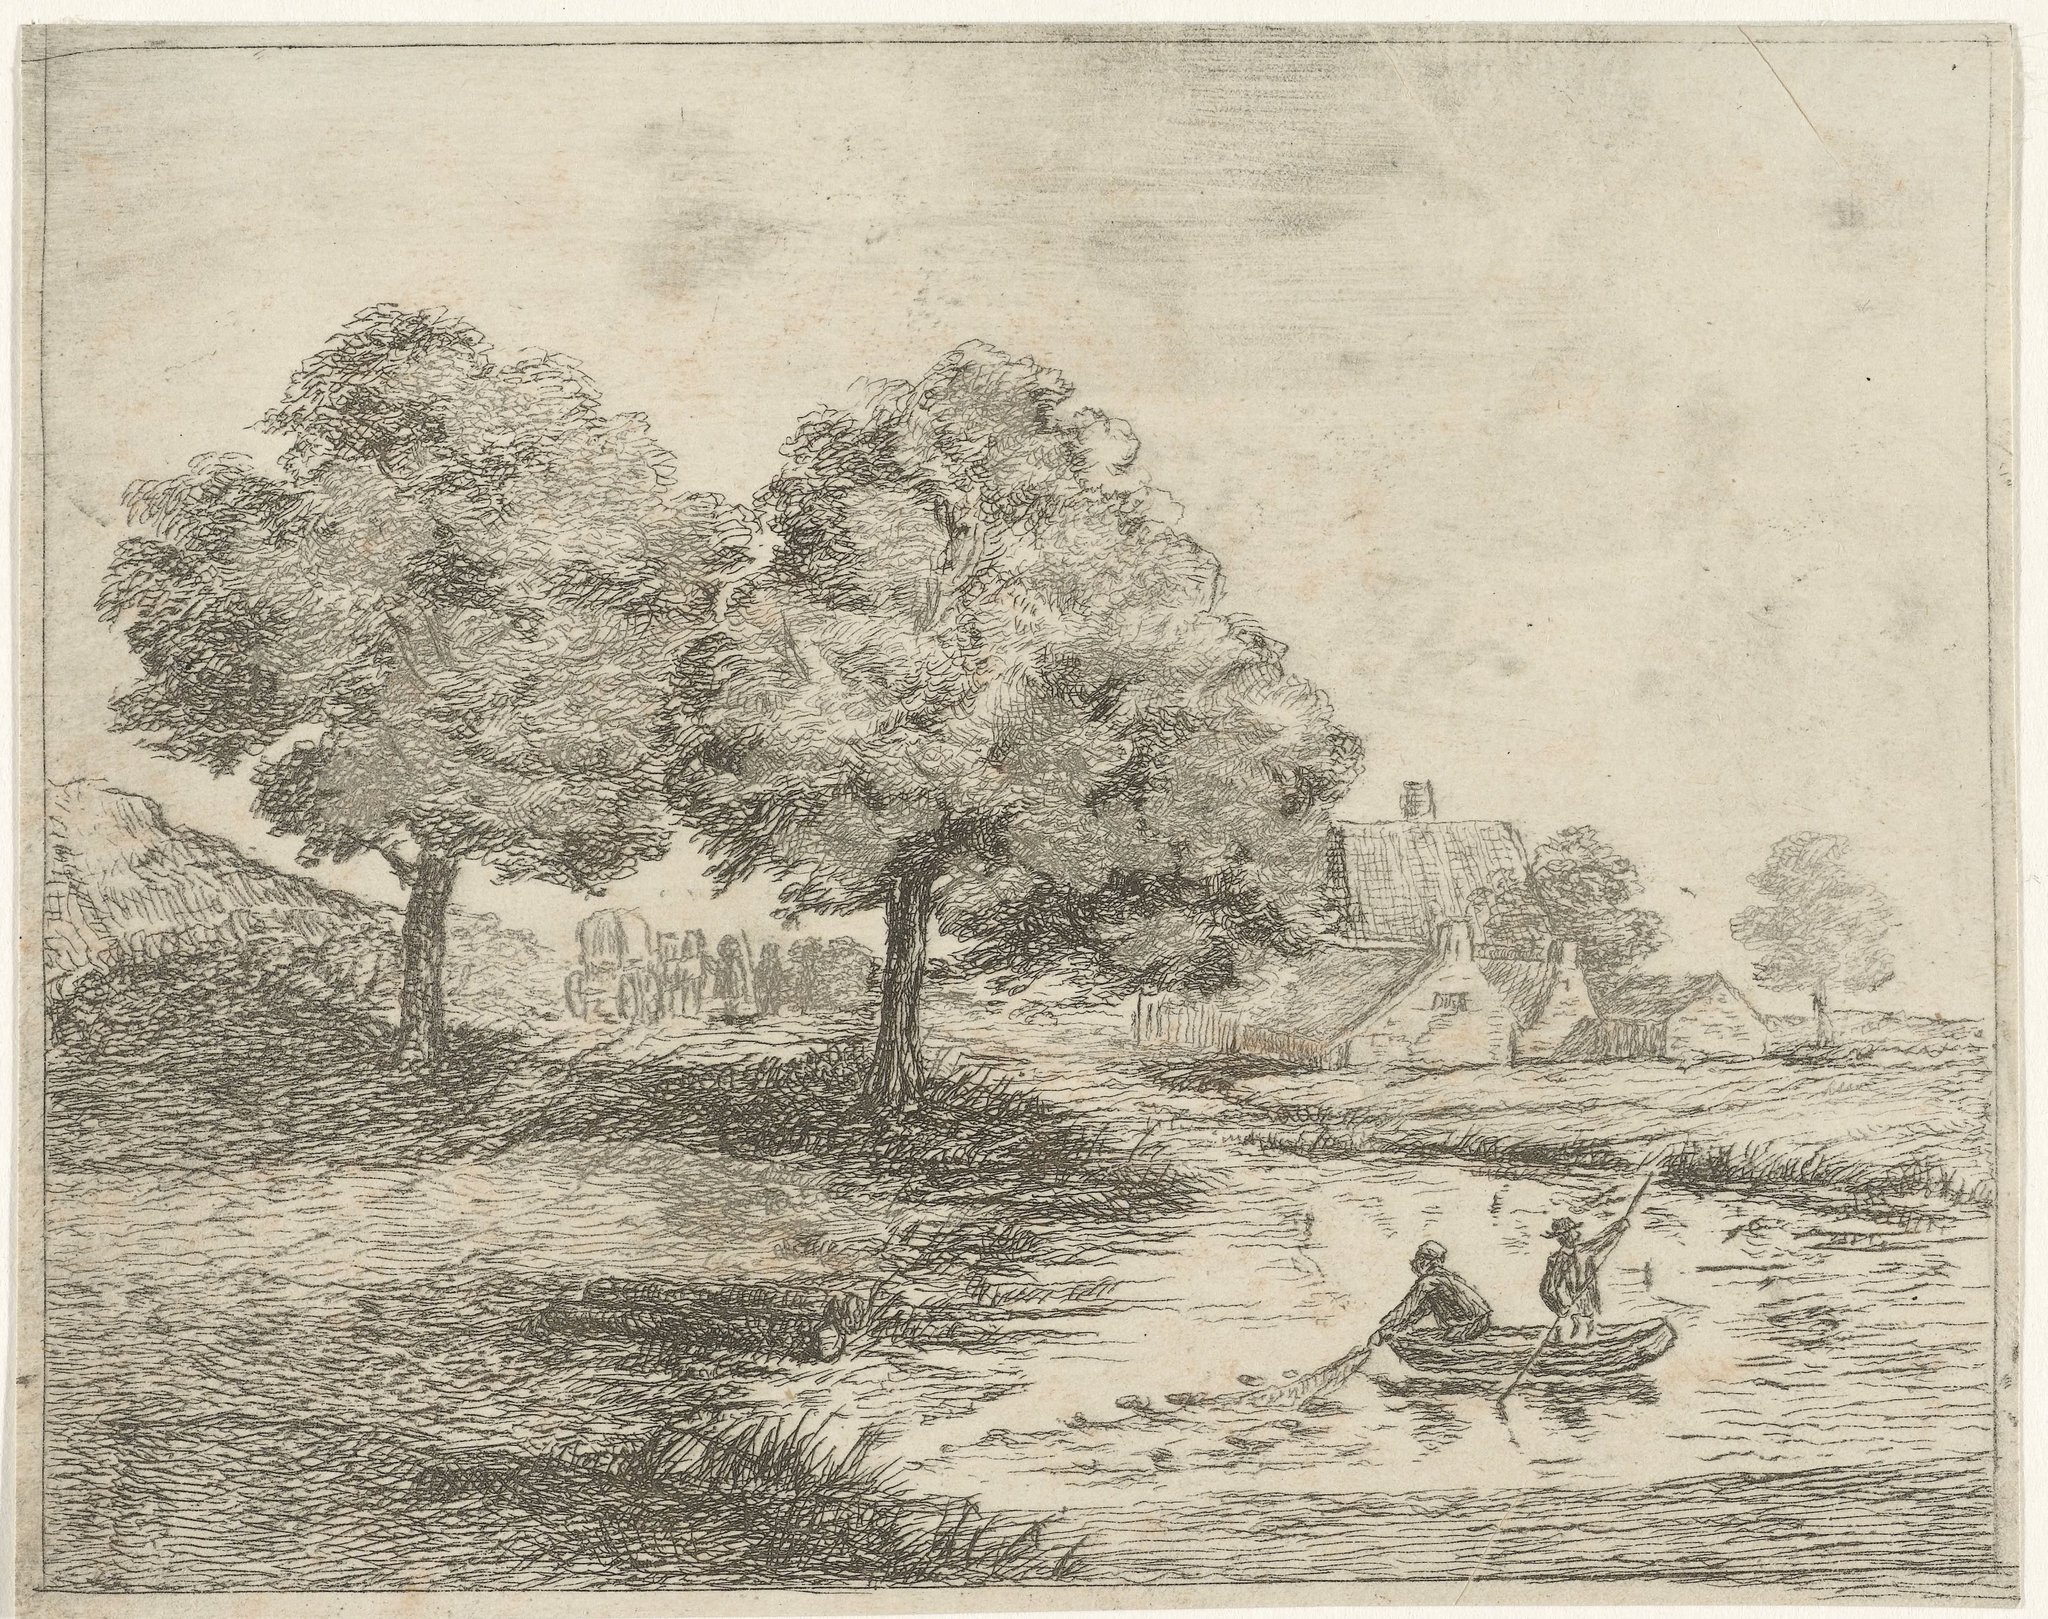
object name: print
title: Landschap met vissers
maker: david van der kellen (1804-1879)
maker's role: die cutter, draughtsman, print maker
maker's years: 1804-1879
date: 1814-1878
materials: paper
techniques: etching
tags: four-wheeled vehicle drawn by one animal, farm or solitary house in landscape, fisherman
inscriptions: inscription, collector's mark: Lugt 2228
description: Twee vissers in een roeiboot hebben hun netten uitgegooid in een sloot. Op de landweg een kar en twee figuren. Boerderij op de achtergrond.